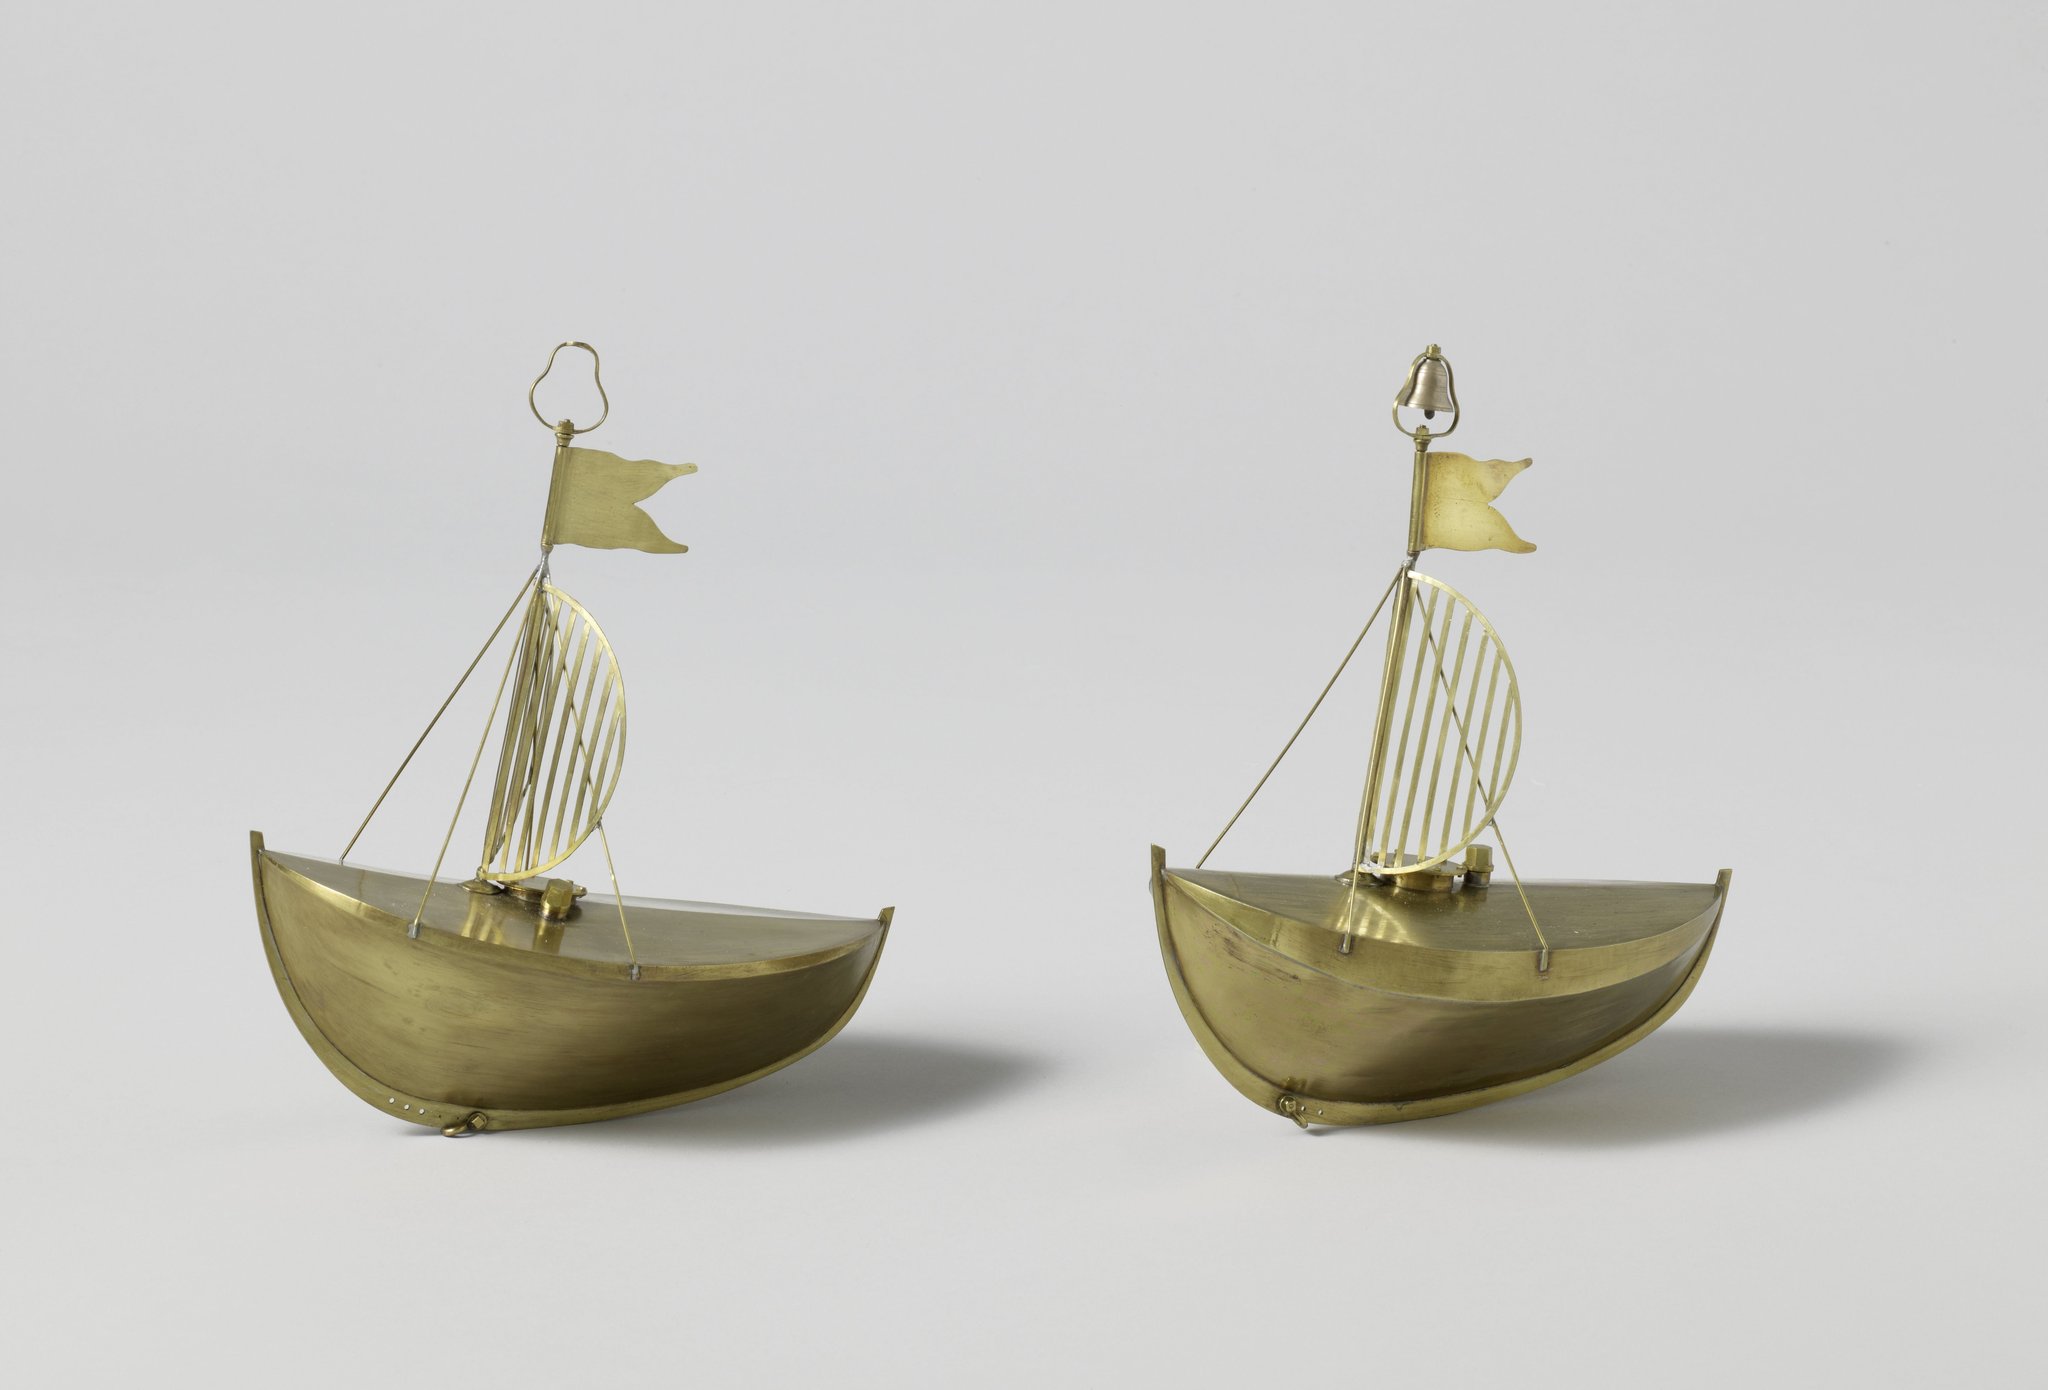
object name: test model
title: Two Models of Floating Beacons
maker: Anonymous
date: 1845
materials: brass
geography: rotterdam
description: Twee nagenoeg identieke modellen van een ijzeren drijfbaken in de vorm van een klein scheepje met een mast met een scherm en een bel. De romp is scherp V-vormig, voorzien van een kiel en met duidelijk onderscheid tussen voor- en achterschip; de bovenkant is afgesloten en voorzien van een mangat en een pomp, die afgesloten is met een zeshoekige schroefdop. Aan de kiel hangt een harpsluiting voor de ankerketting, die op drie verschillende plaatsen gezet kan worden. De masten zijn gestaagd met vier stagen, die op ware grootte in stafijzer worden uitgevoerd, twee voor en twee achter. De schermen bestaan uit twee halve cirkels, die in het vlak van de mast en de bakstagen zijn geplaatst. De windvanen hebben een V-vormige uitsnede en de bel is vast gemonteerd terwijl de klepel de bel aanslaat door de beweging van de boei op de golven. De boeien hebben een iets verschillende rompvorm.